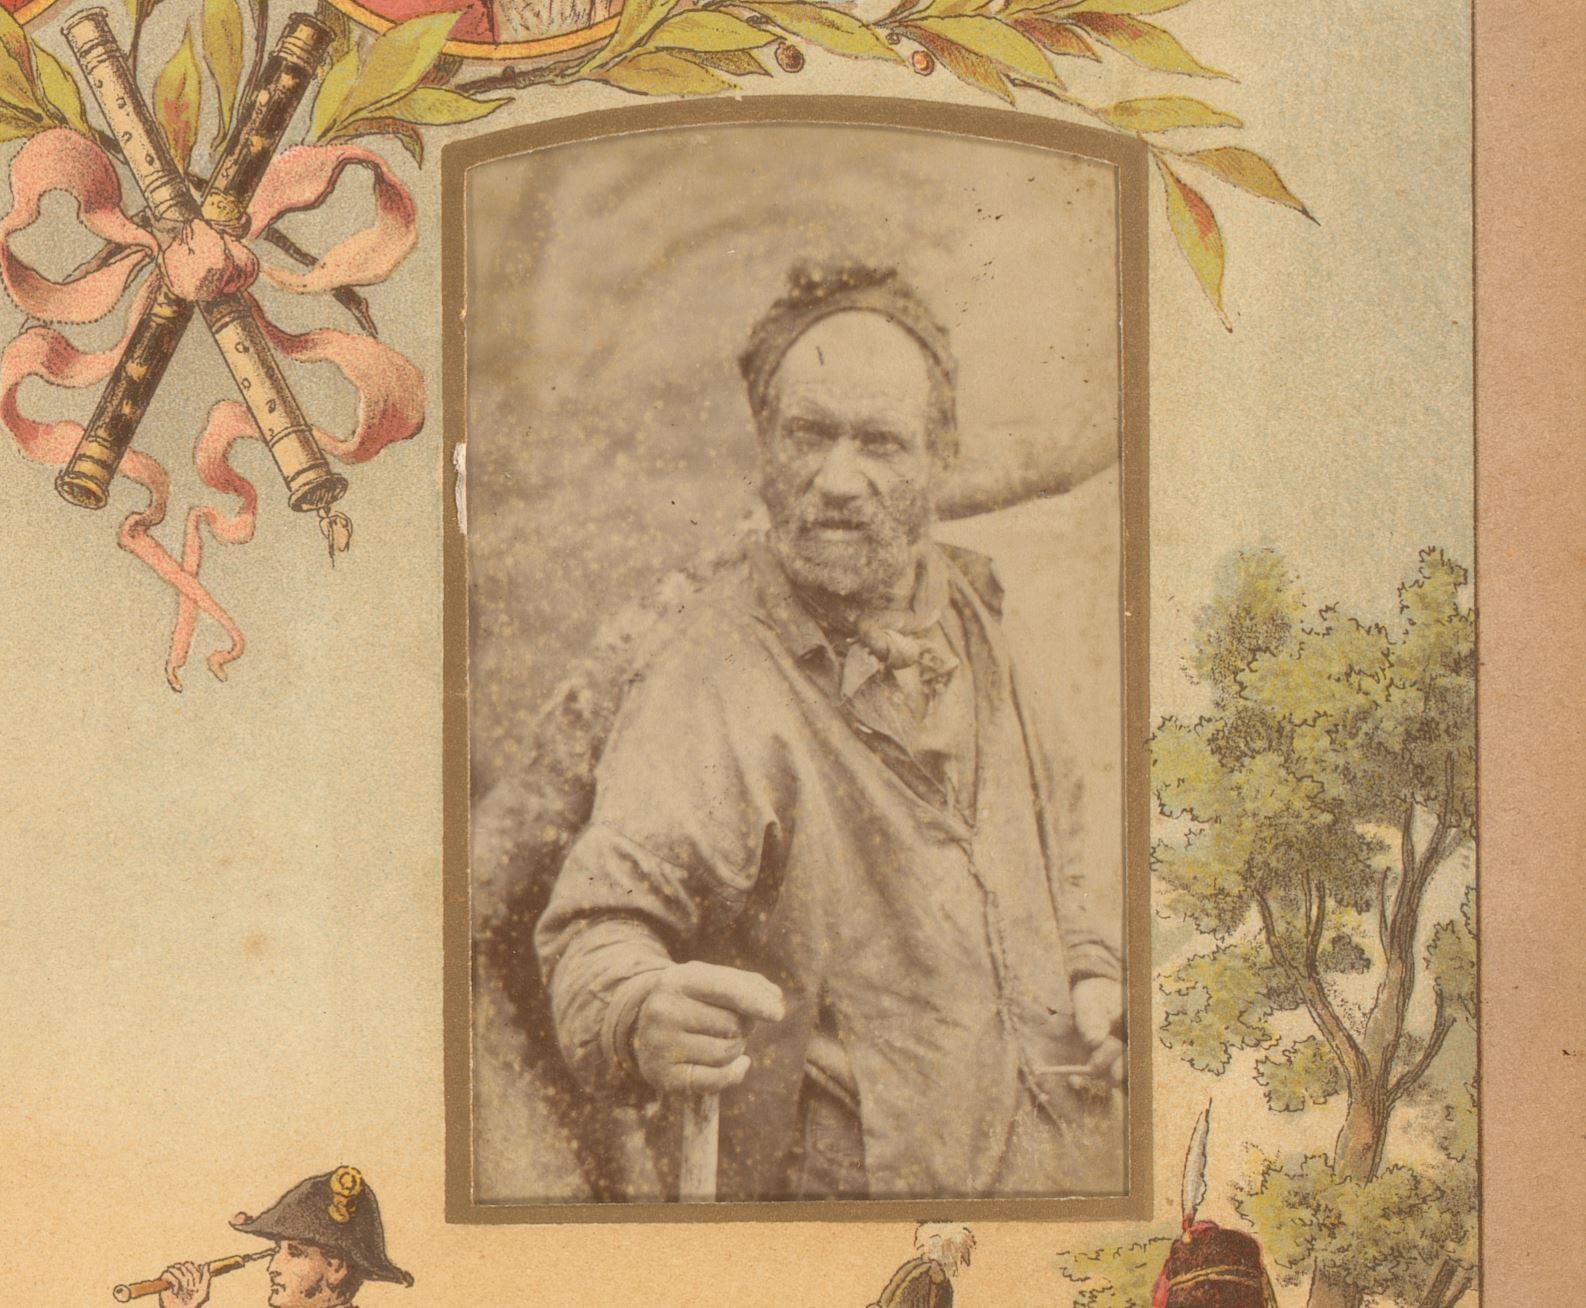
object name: carte de visite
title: Portret van een arbeider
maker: Anonymous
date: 1860-1880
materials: cardboard, photographic support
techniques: albumen print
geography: england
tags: historical persons, working class, labourers